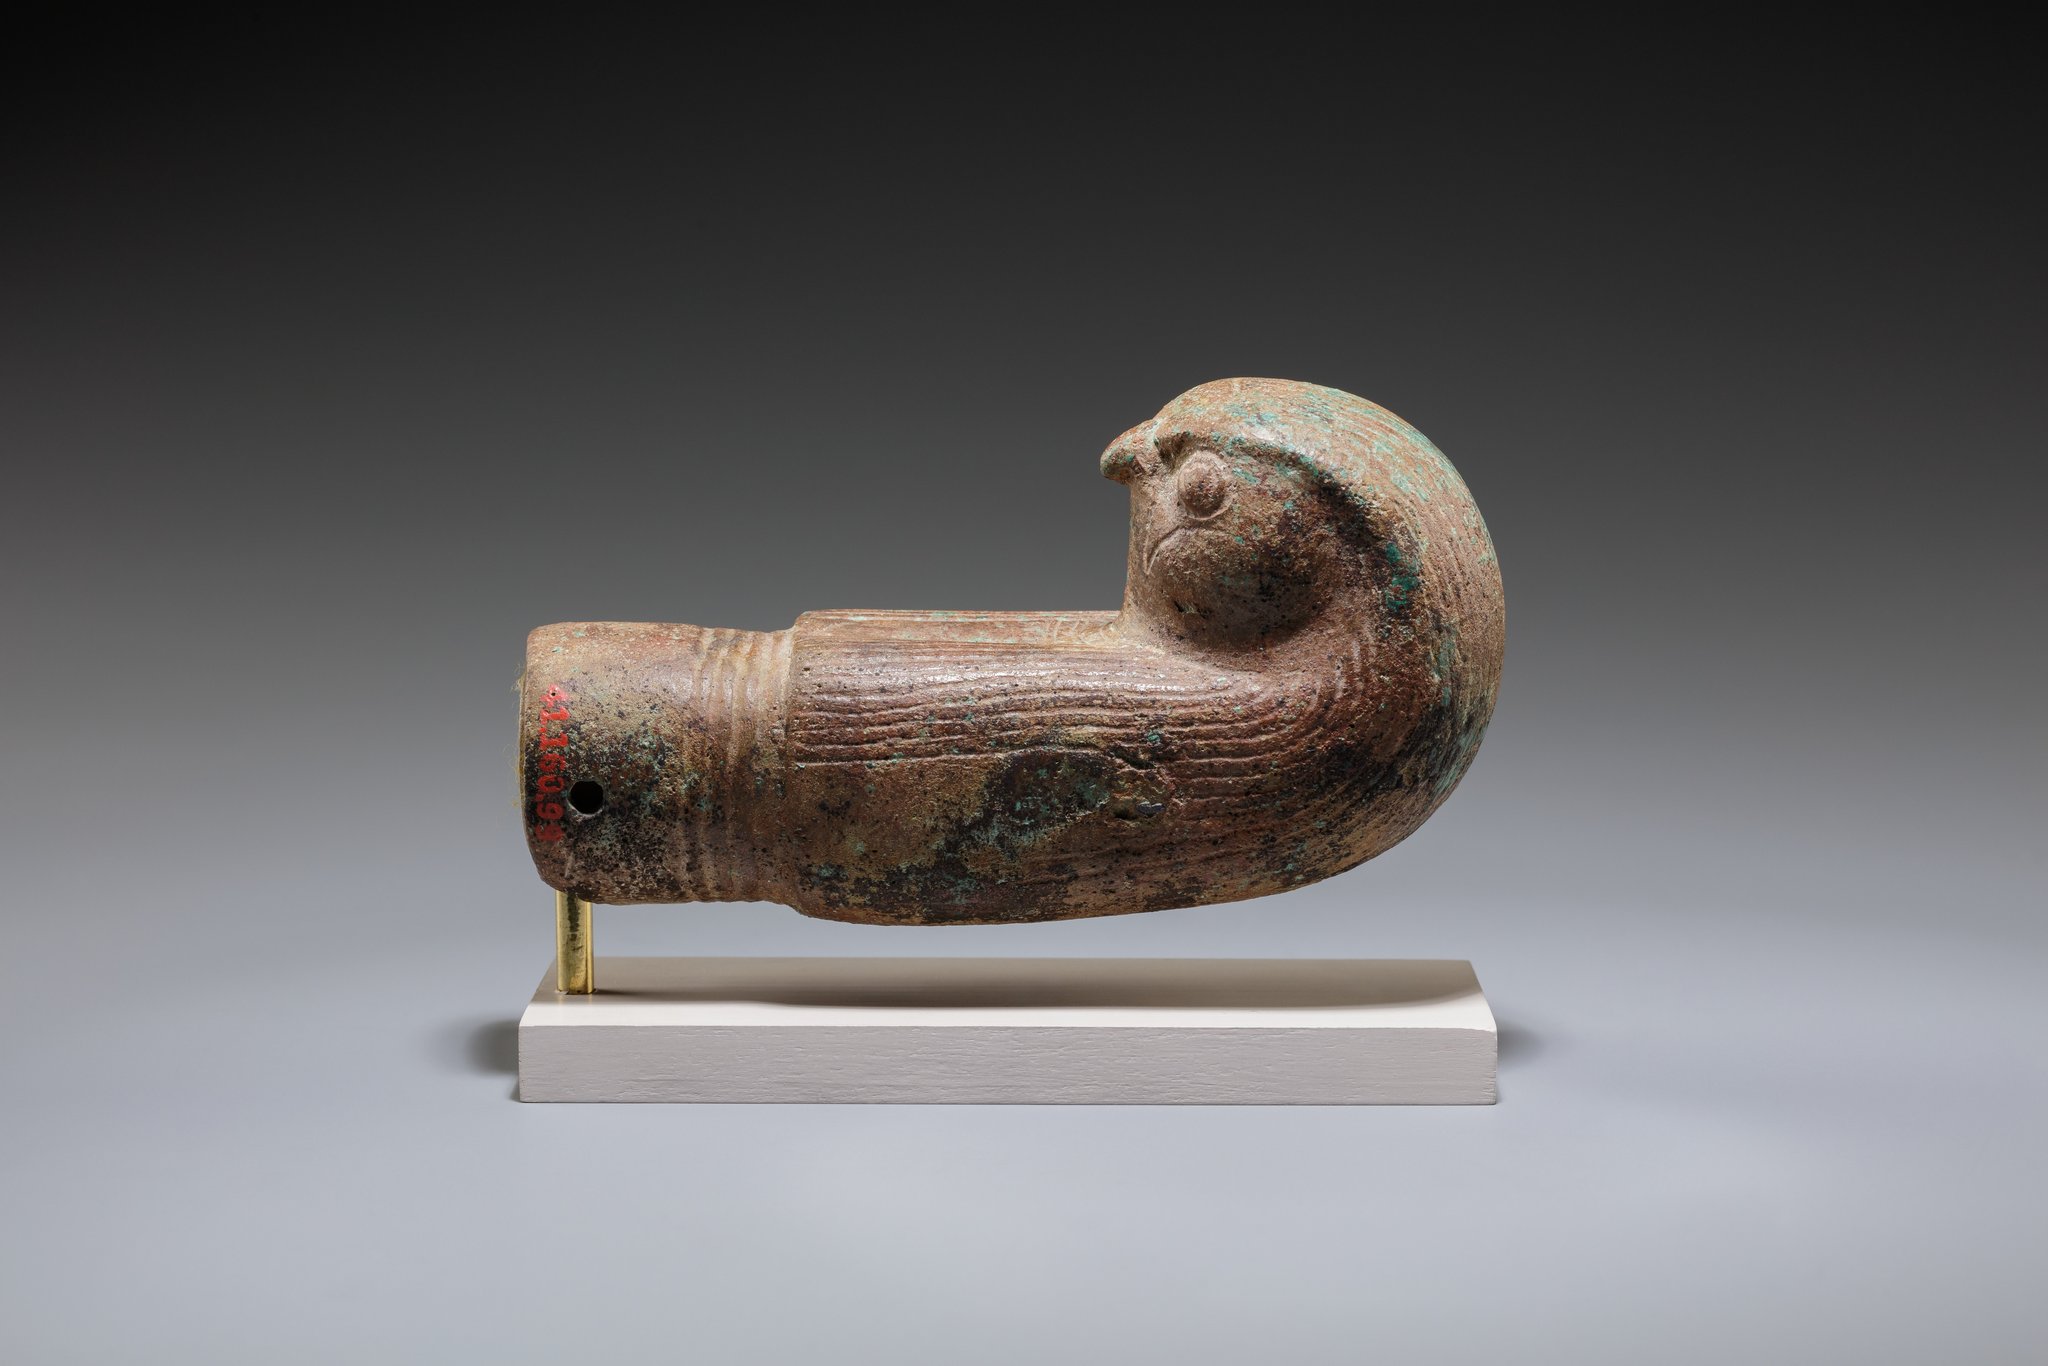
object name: censer handle, falcon head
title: Handle of censer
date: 664-332 BCE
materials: bronze, copper alloy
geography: egypt